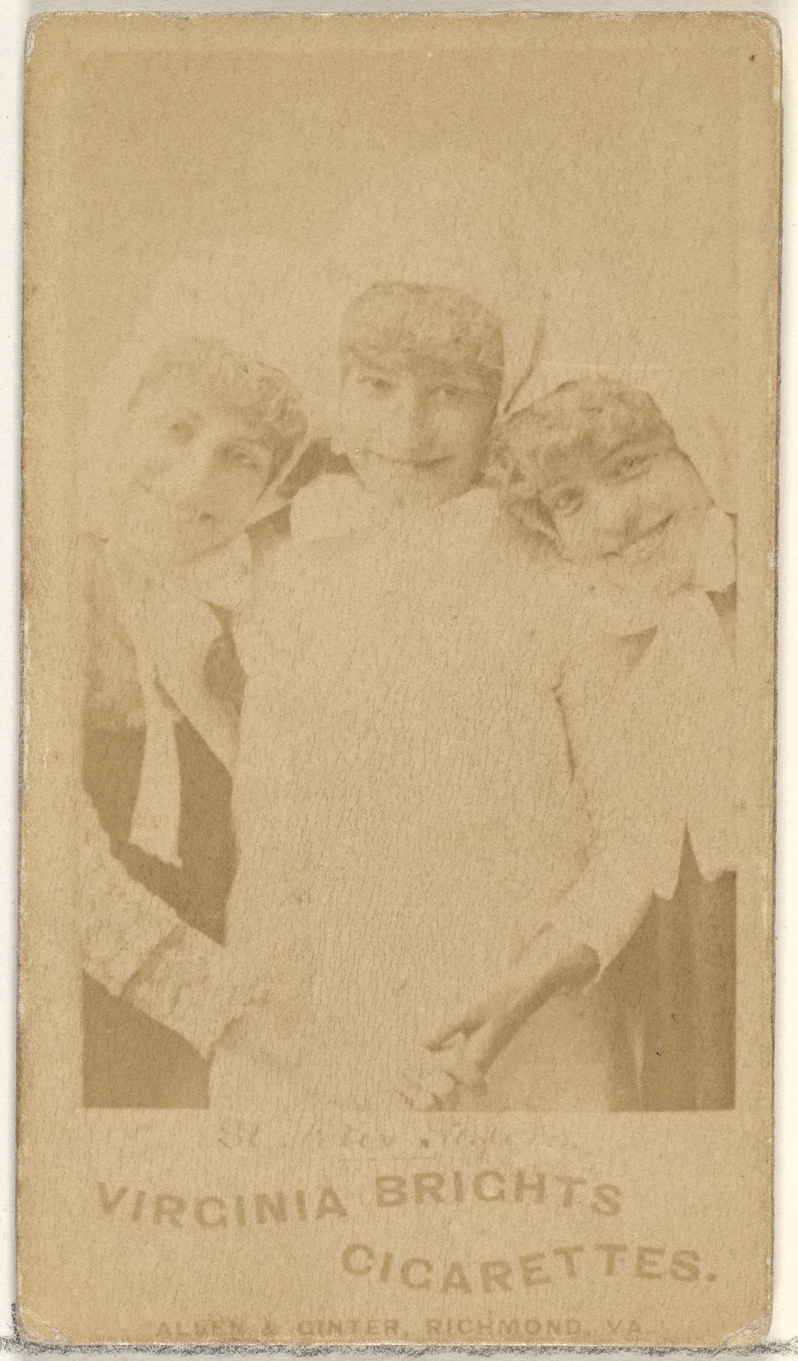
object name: photograph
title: St. Felix Sisters, From the Actors and Actresses series (N45, Type 1) for Virginia Brights Cigarettes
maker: allen & ginter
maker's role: publisher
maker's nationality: american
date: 1888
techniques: albumen silver print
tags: girls,portraits,actresses